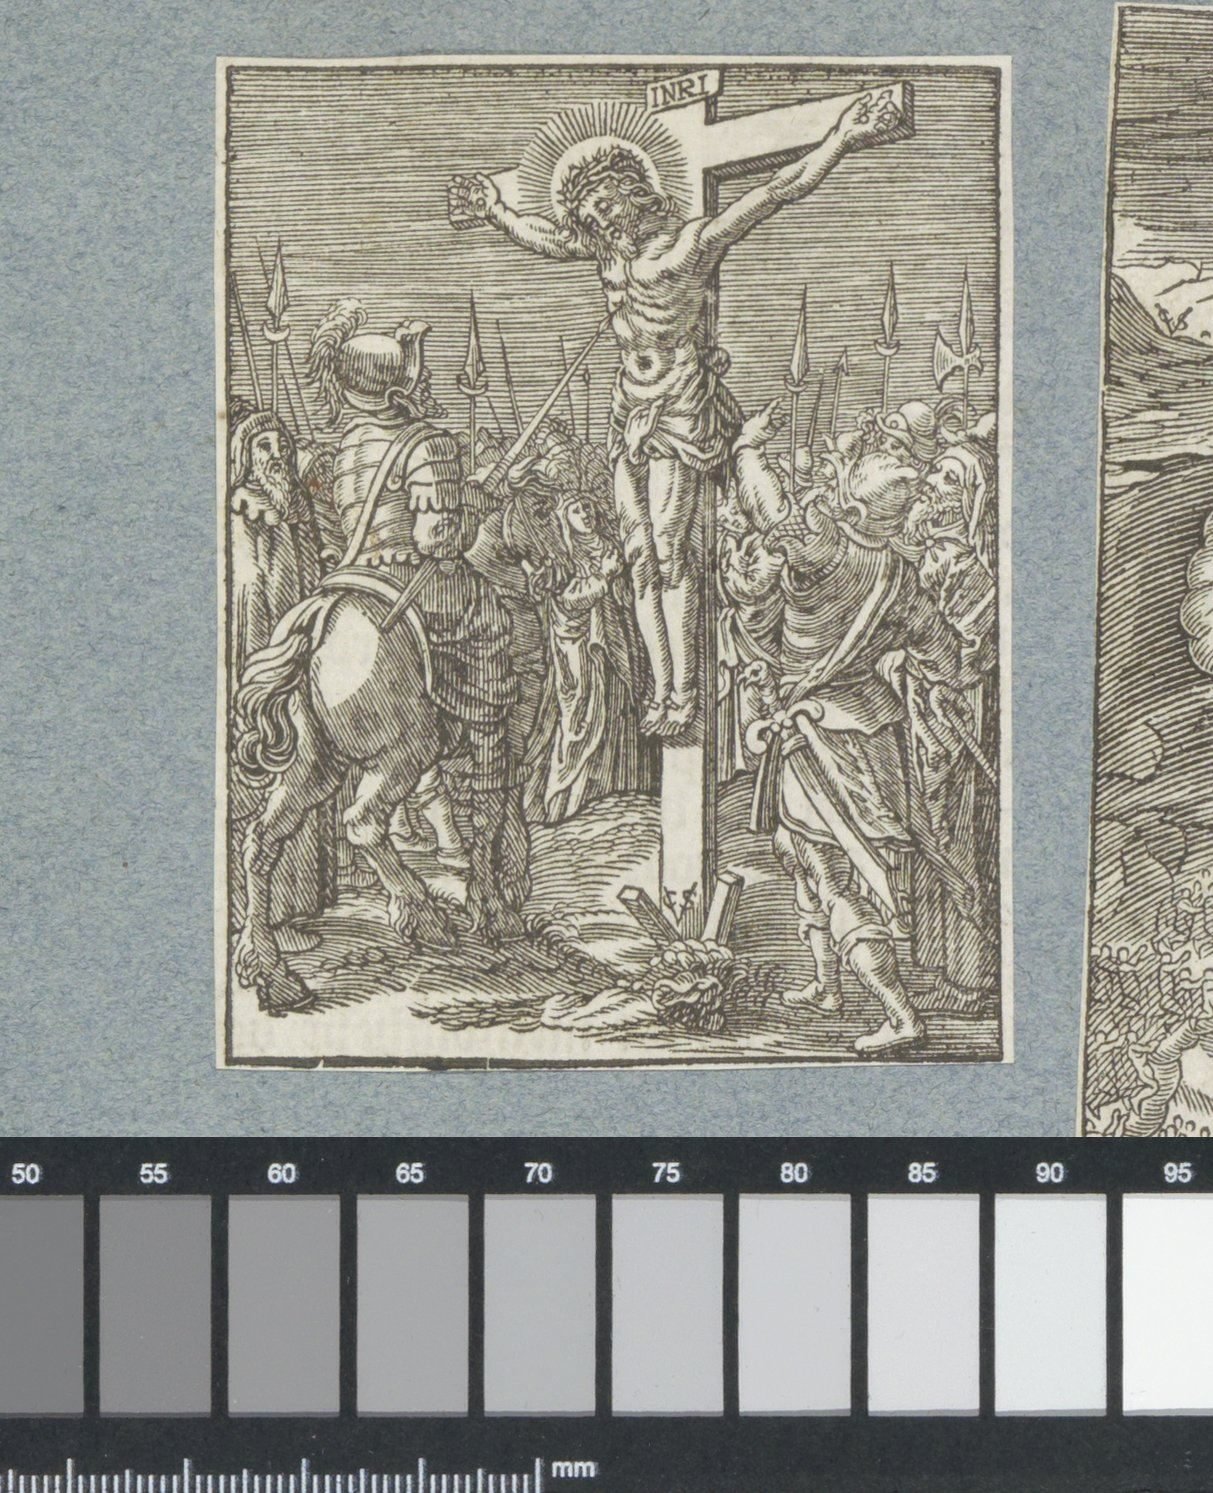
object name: album leaf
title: Christus aan het kruis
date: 1628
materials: paper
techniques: letterpress printing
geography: amsterdam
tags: longinus pierces christ's side with a lance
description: De prent is afkomstig uit een van de uitgaven van P.J. Paets uit Amsterdam. De prent wordt voor het eerst gebruikt in: Thomas à Kempis, Qui Sequitur me. Leuven, J. Maes, 1628 [= Amsterdam, P.J. Paets] of Der Zielen Lust-hof. Leuven, I.Jacbosz voor P.J. Paets [= Amsterdam, P.J. Paets], 1629. De voorstelling is gekopieerd naar een prent van Hieronymus Wierix.